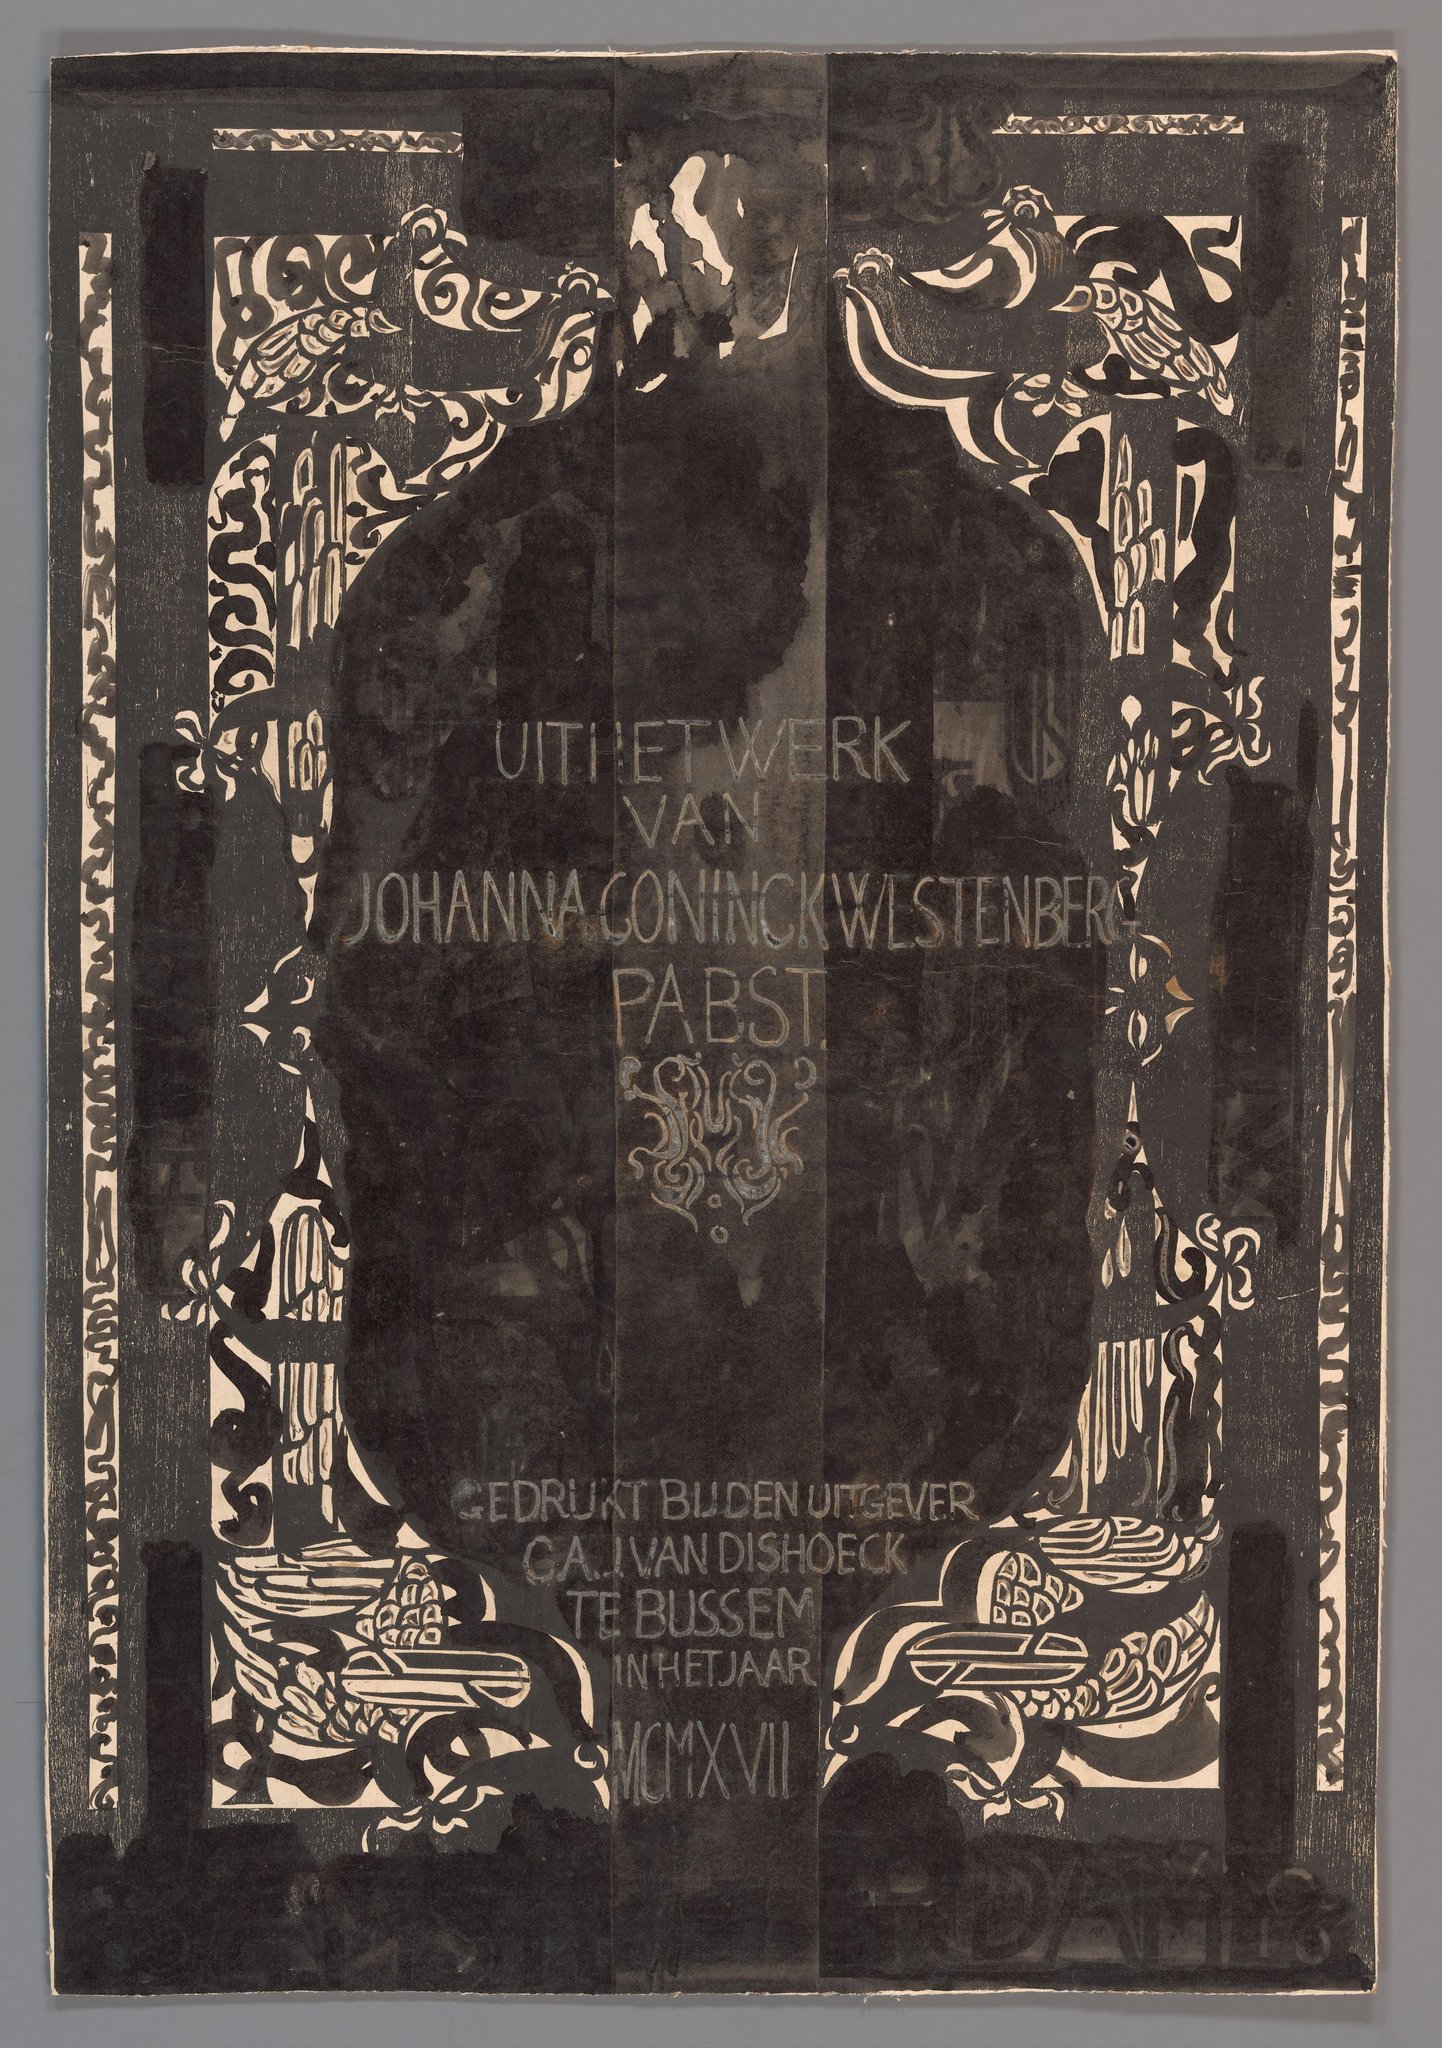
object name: design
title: Ontwerp voor boekband van Uit het werk van Johanna Coninckwestenberg Pabst, Bussum 1917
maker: carel adolph lion cachet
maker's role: draughtsman, print maker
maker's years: 1864-1945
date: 1874-1945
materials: cardboard, paint, paper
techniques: brush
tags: (johanna pabst, uit het werk van johanna pabst) specific works of literature (with author, title), book-cover, binding